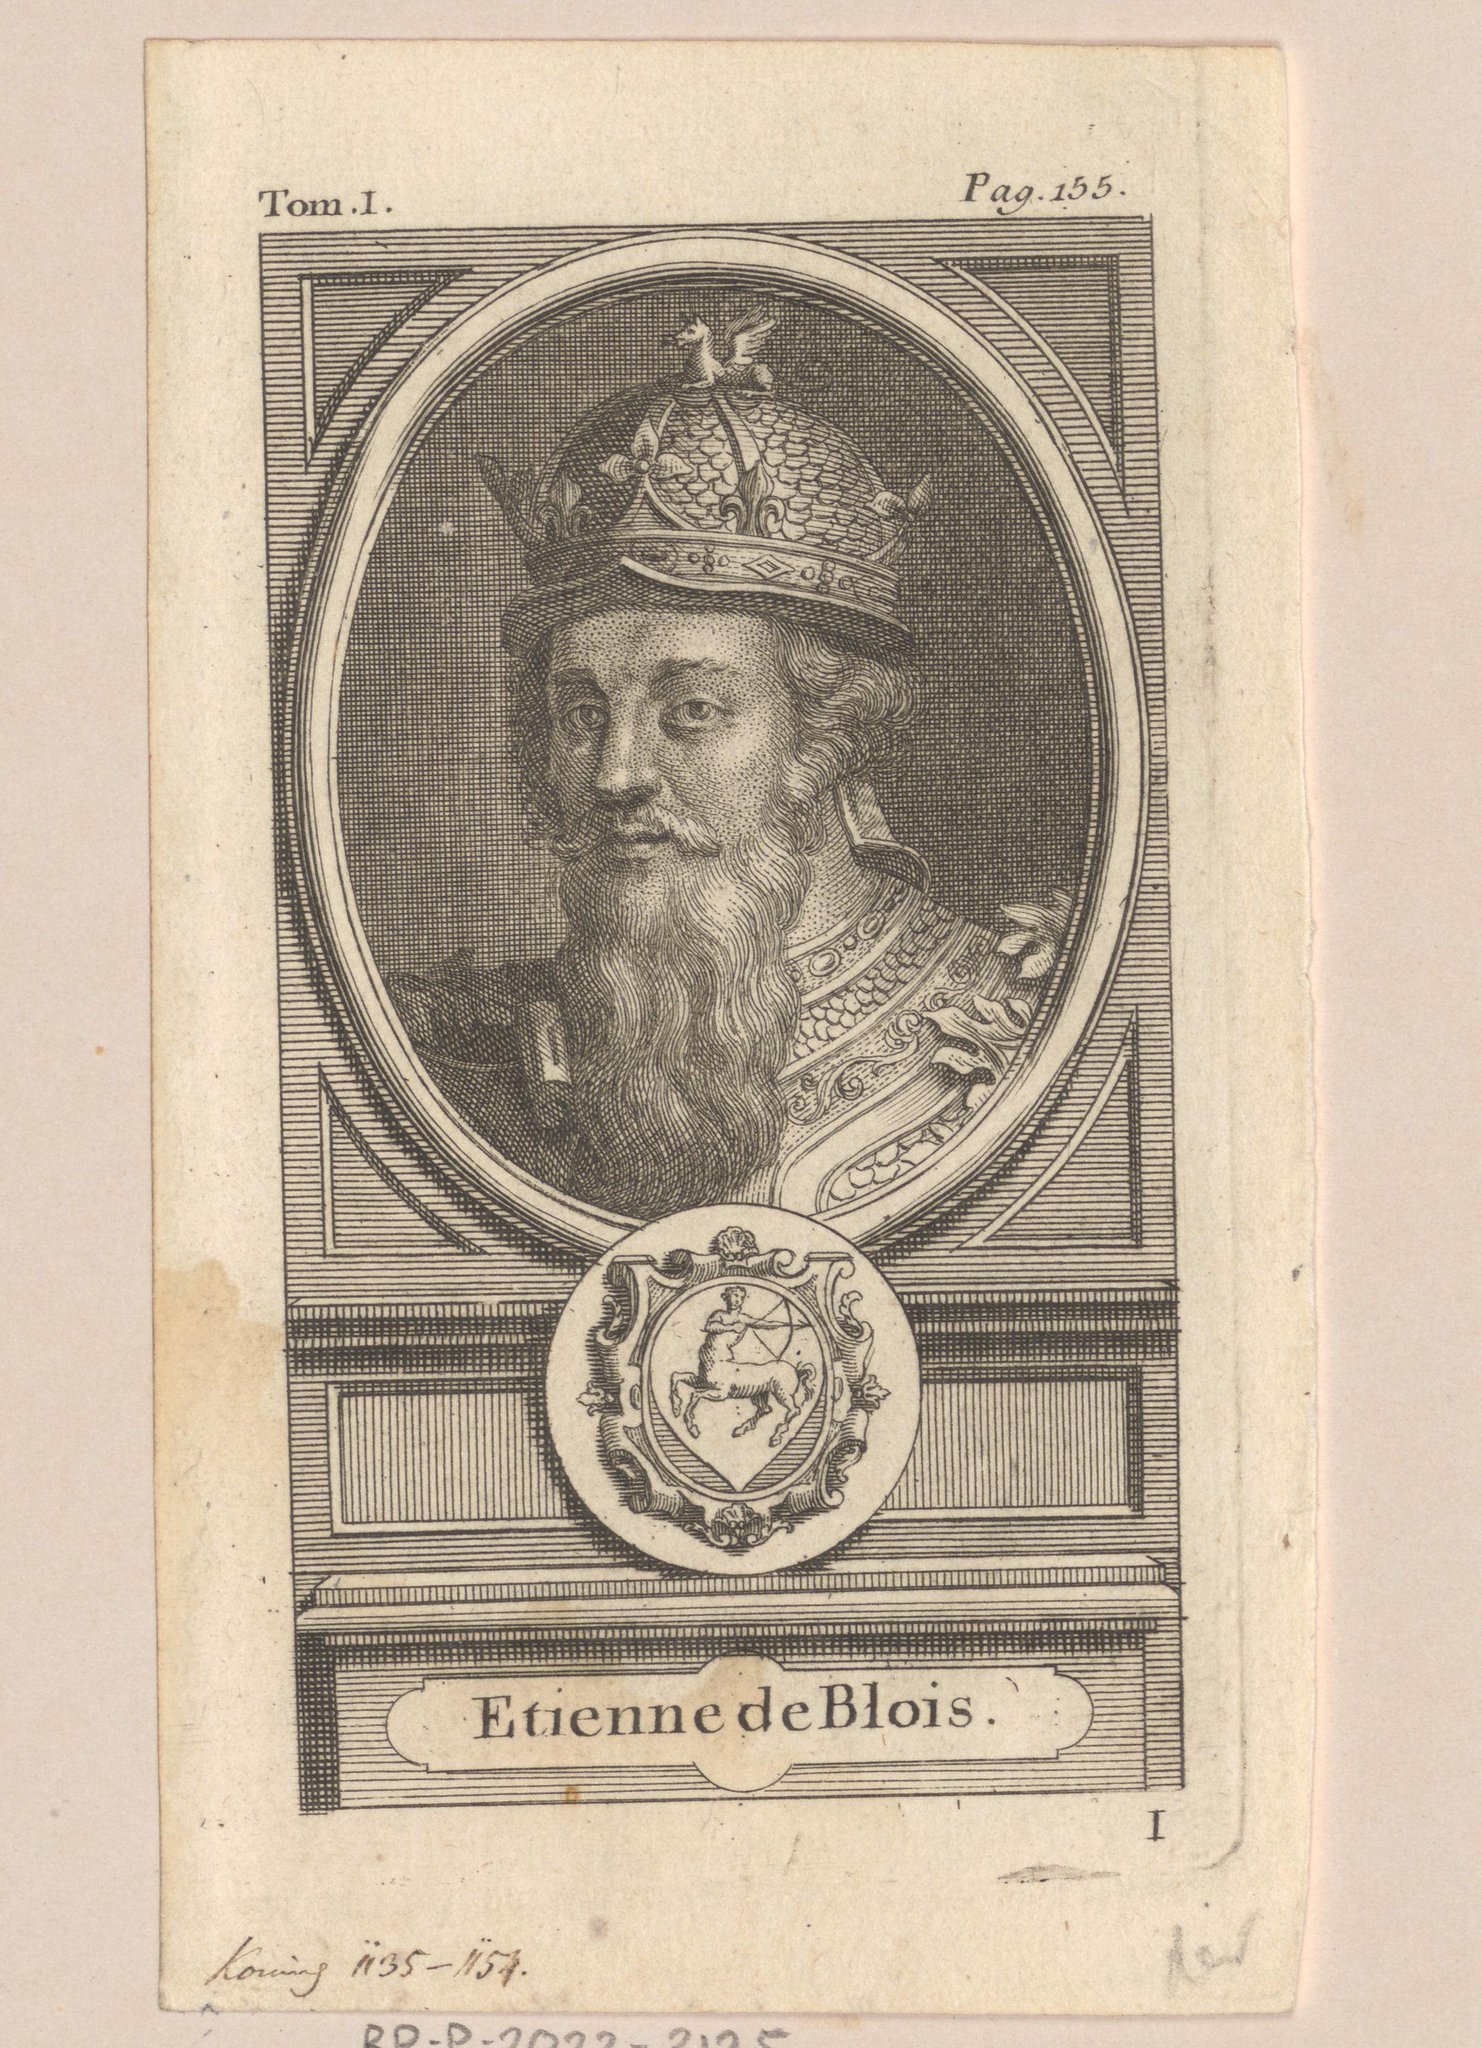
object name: print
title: Portret van Stefanus van Engeland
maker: Anonymous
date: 1750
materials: paper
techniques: engraving, etching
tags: historical persons, king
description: Prent waarschijnlijk uit: Orleans, Pierre Joseph d’. Histoire des revolutions d'Angleterre, depuis le commencement de la monarchie. Parijs: Pierre-François Giffart en Jacques Rolin, 1750, dl. 1. Prent ook gebruikt in de 1762-editie uitgegeven in Lyon door de gebroeders Duplain. Mogelijk ook gebruikt in andere edities of andere publicaties.